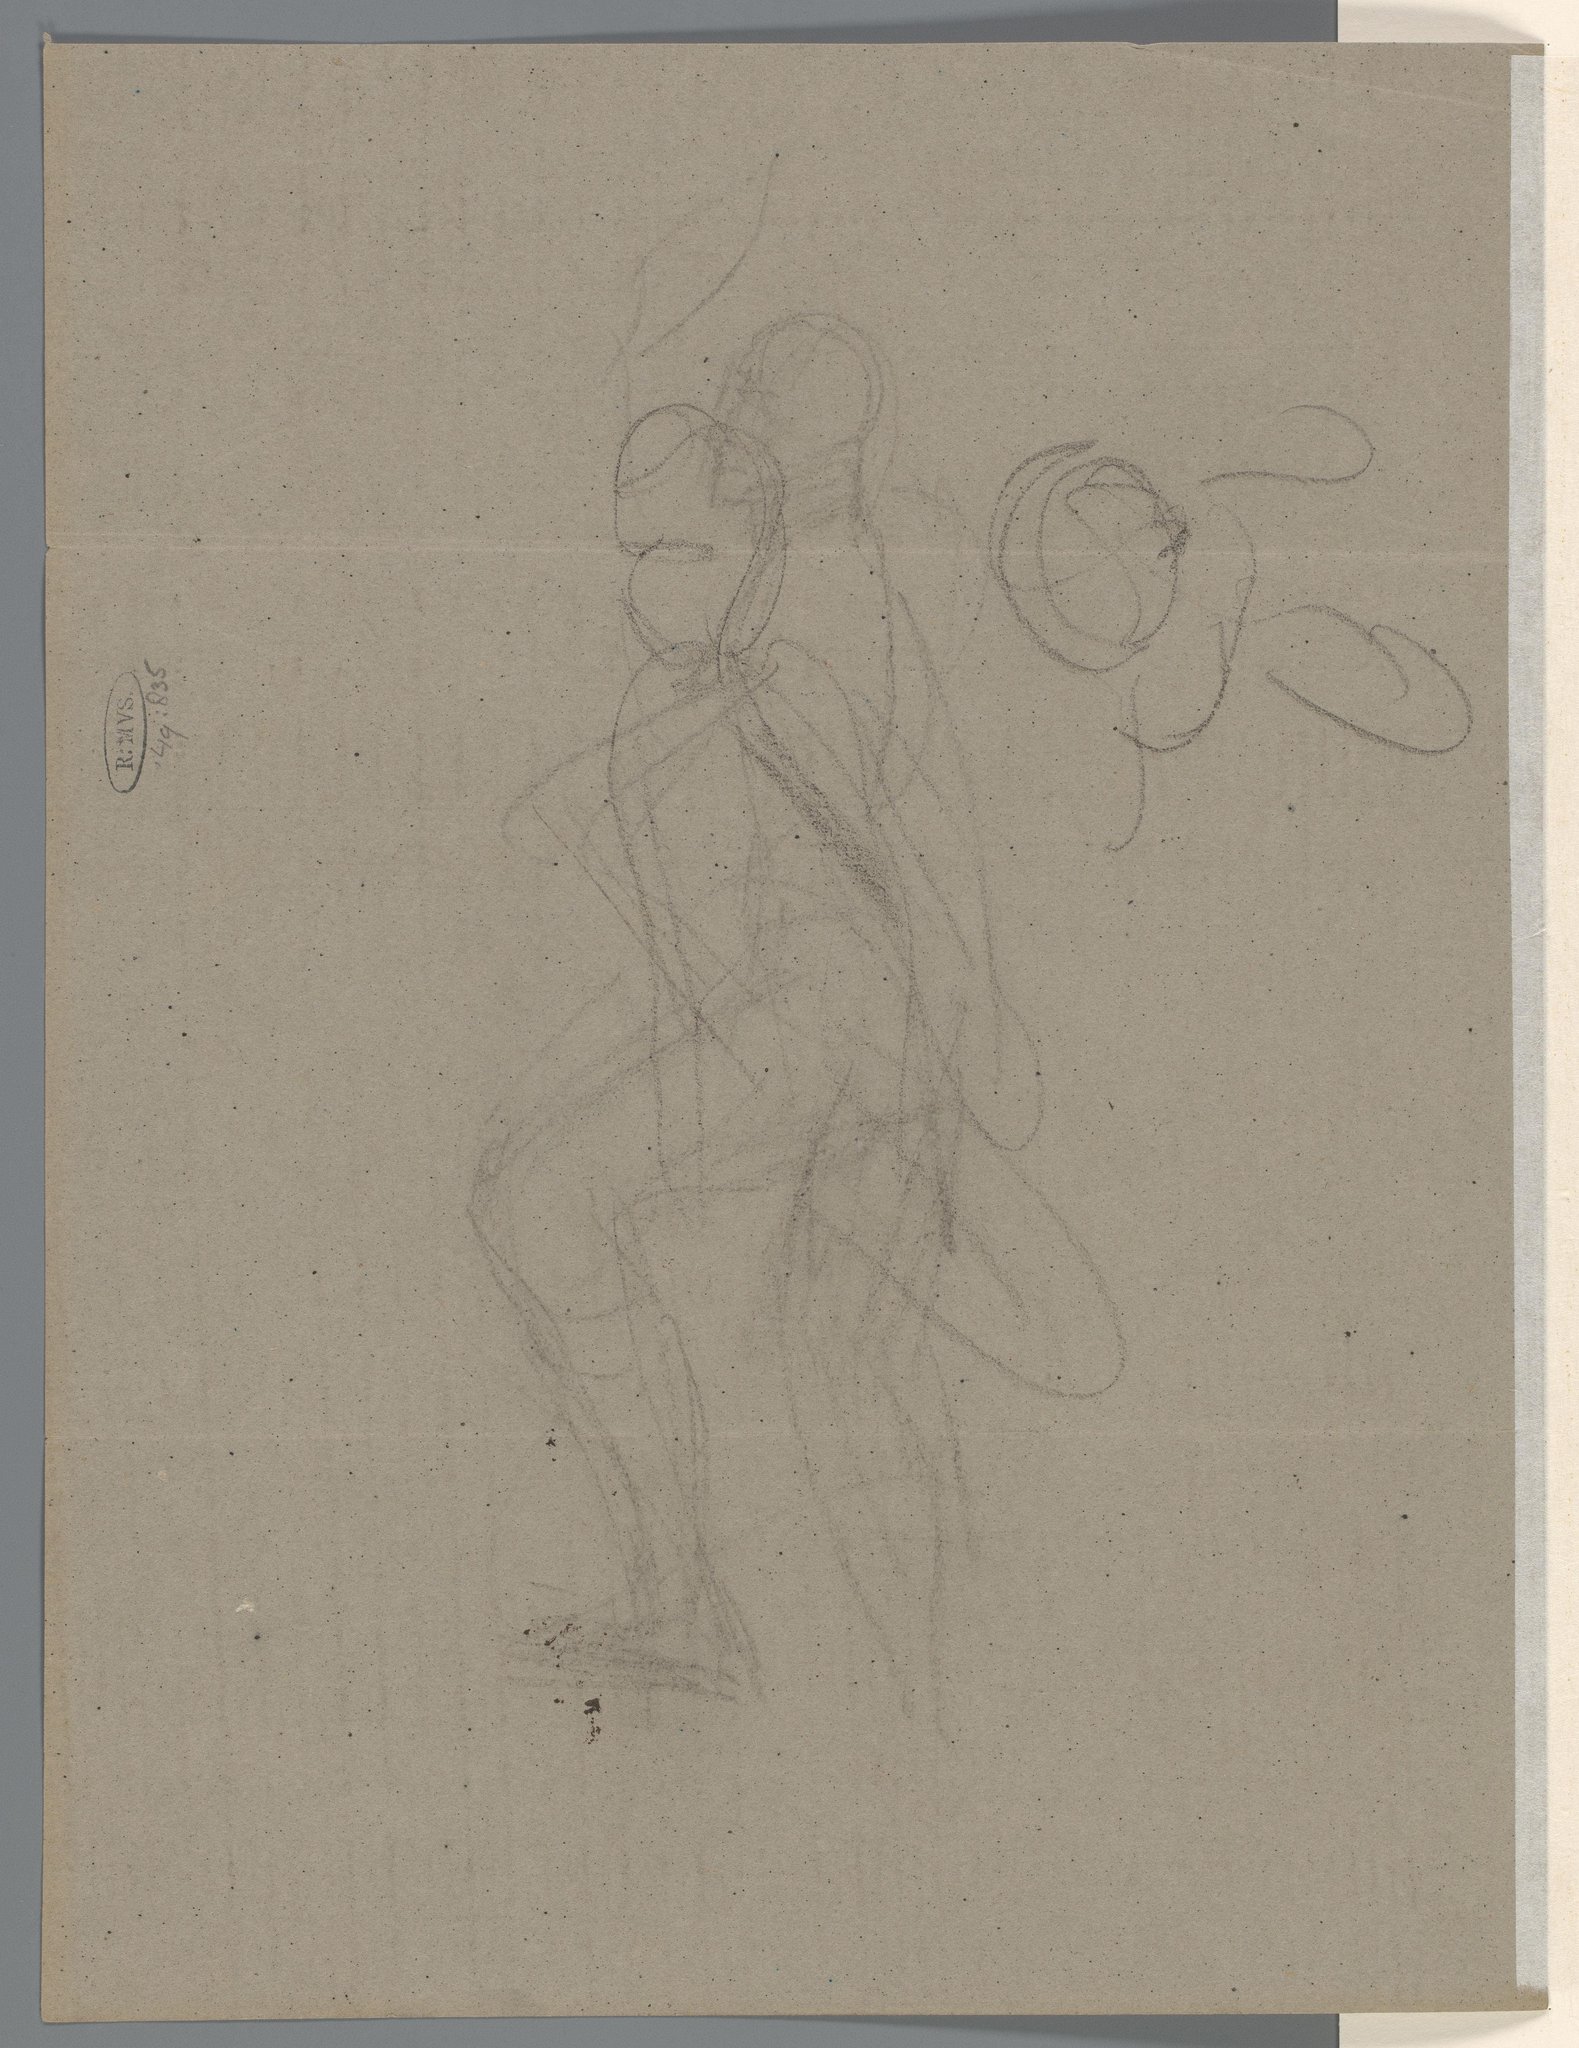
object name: drawing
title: Figuurstudie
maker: august allebé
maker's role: draughtsman, print maker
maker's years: 1838-1927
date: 1848-1927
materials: chalk, paper